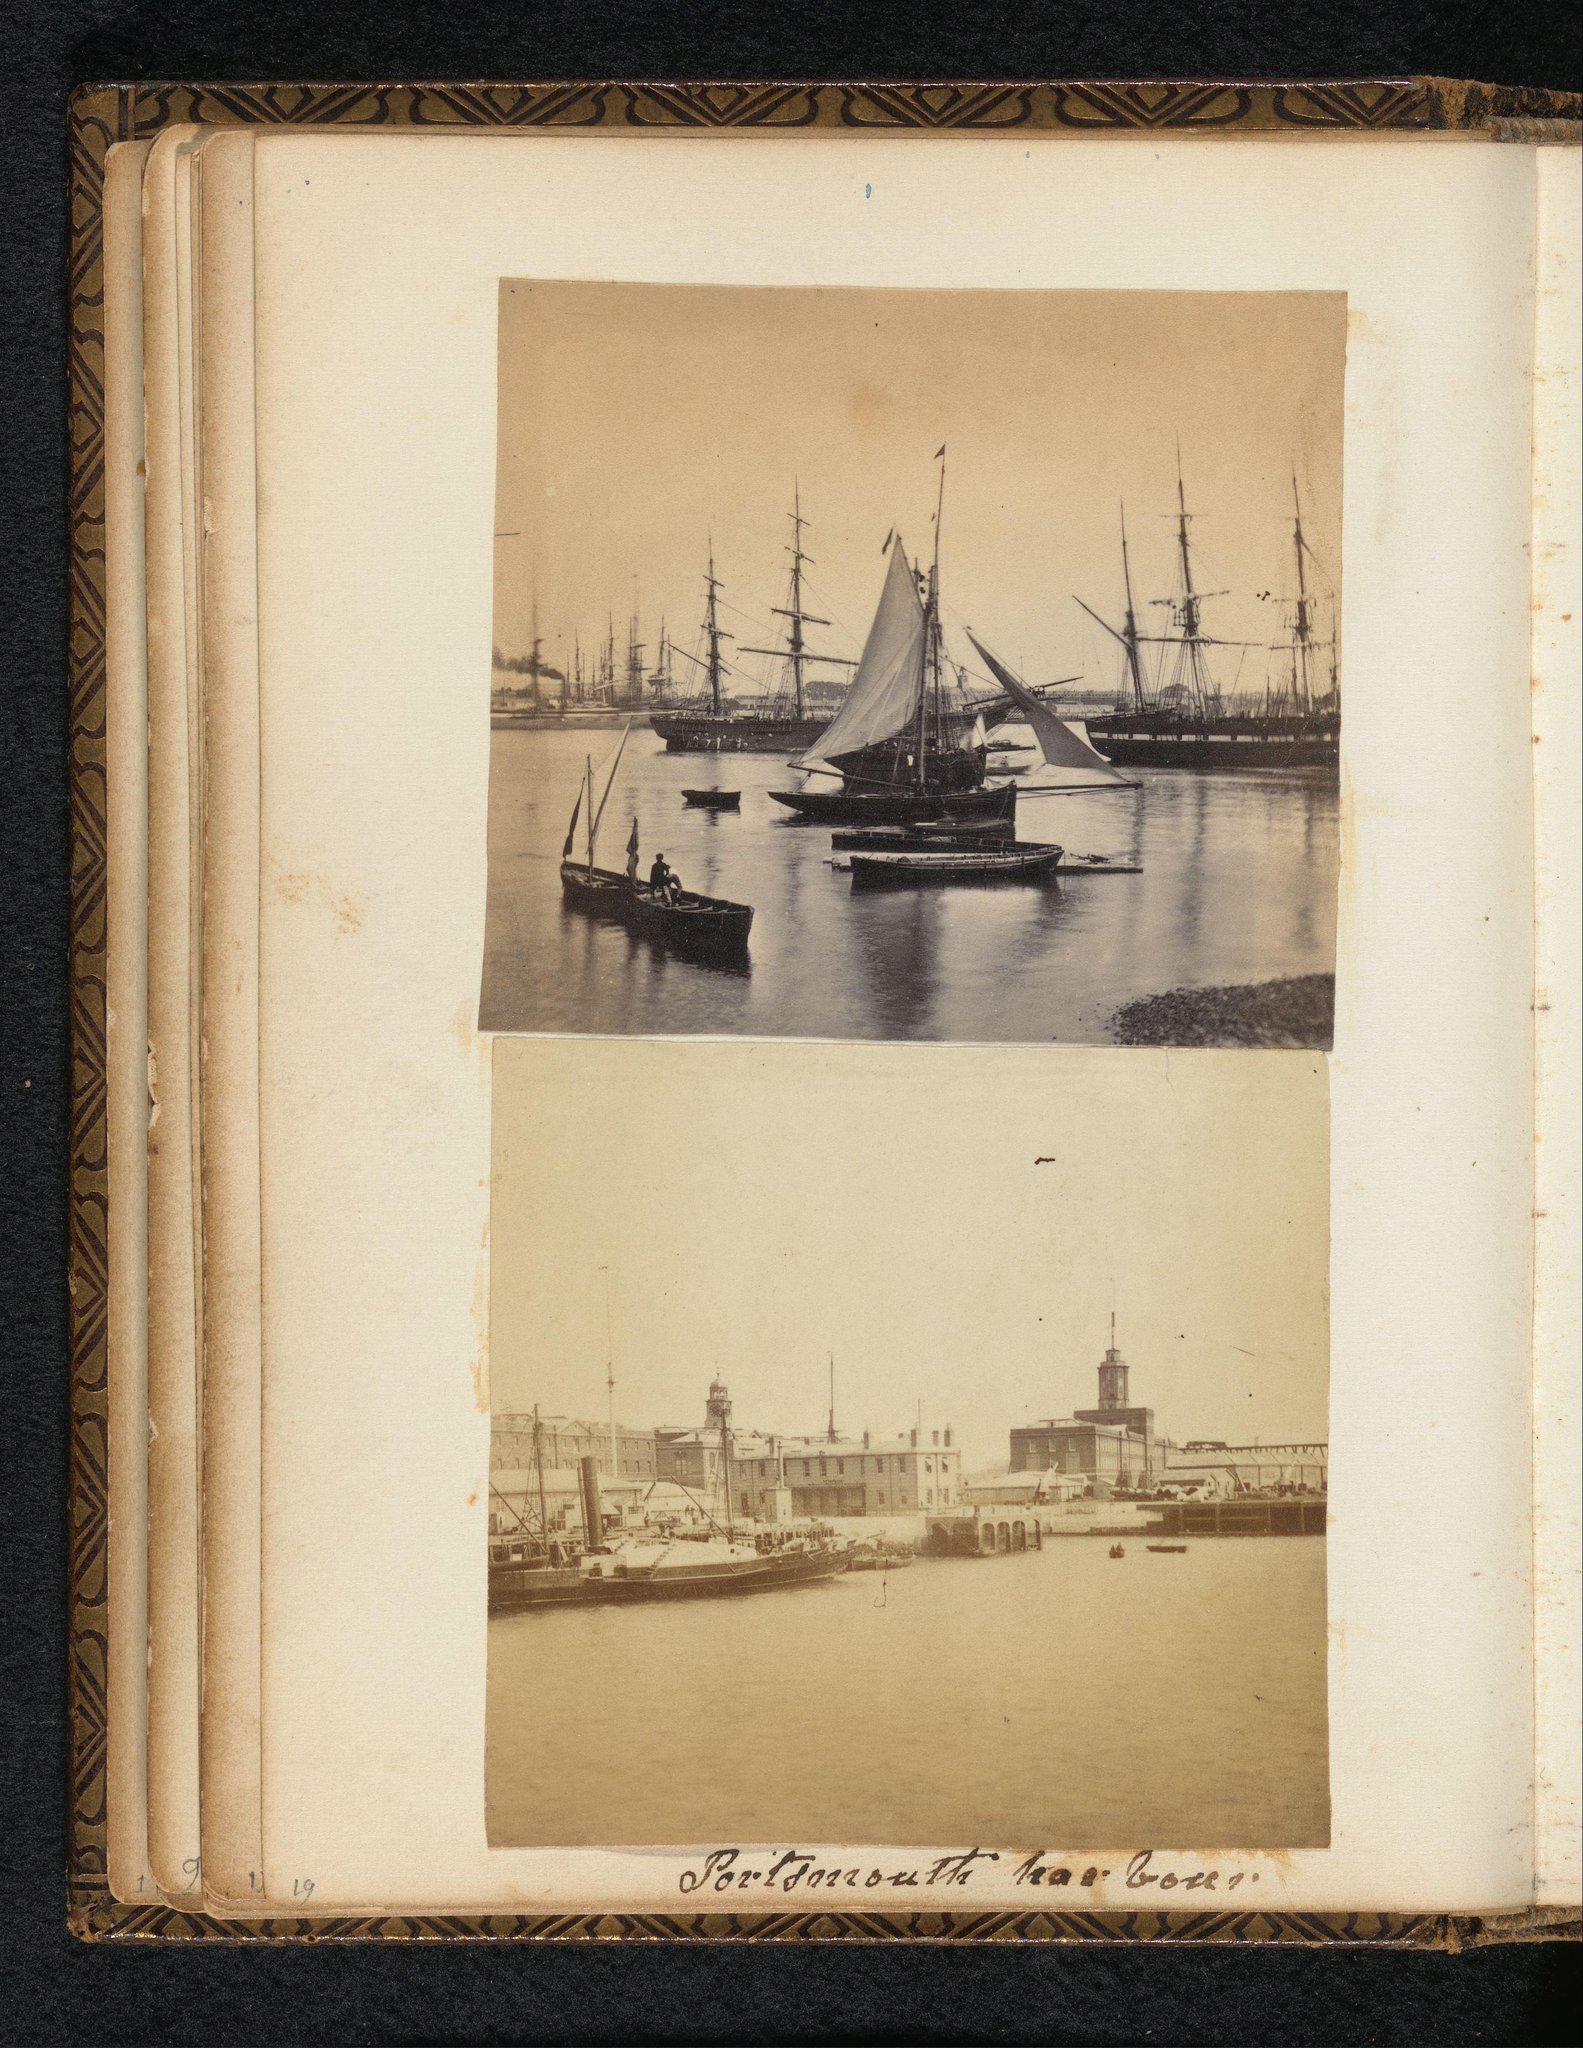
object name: photograph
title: Portsmouth harbour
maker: Anonymous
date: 1865-1867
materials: cardboard, photographic support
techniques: albumen print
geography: england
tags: harbour, portsmouth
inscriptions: annotation: ‘Portsmouth harbour’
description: Twee foto's in de haven van Portsmouth. Foto's op albumblad in album met 68 foto's merendeels met geaquarelleerde randversieringen. Het zijn voornamelijk portretten op carte-de-visite formaat.